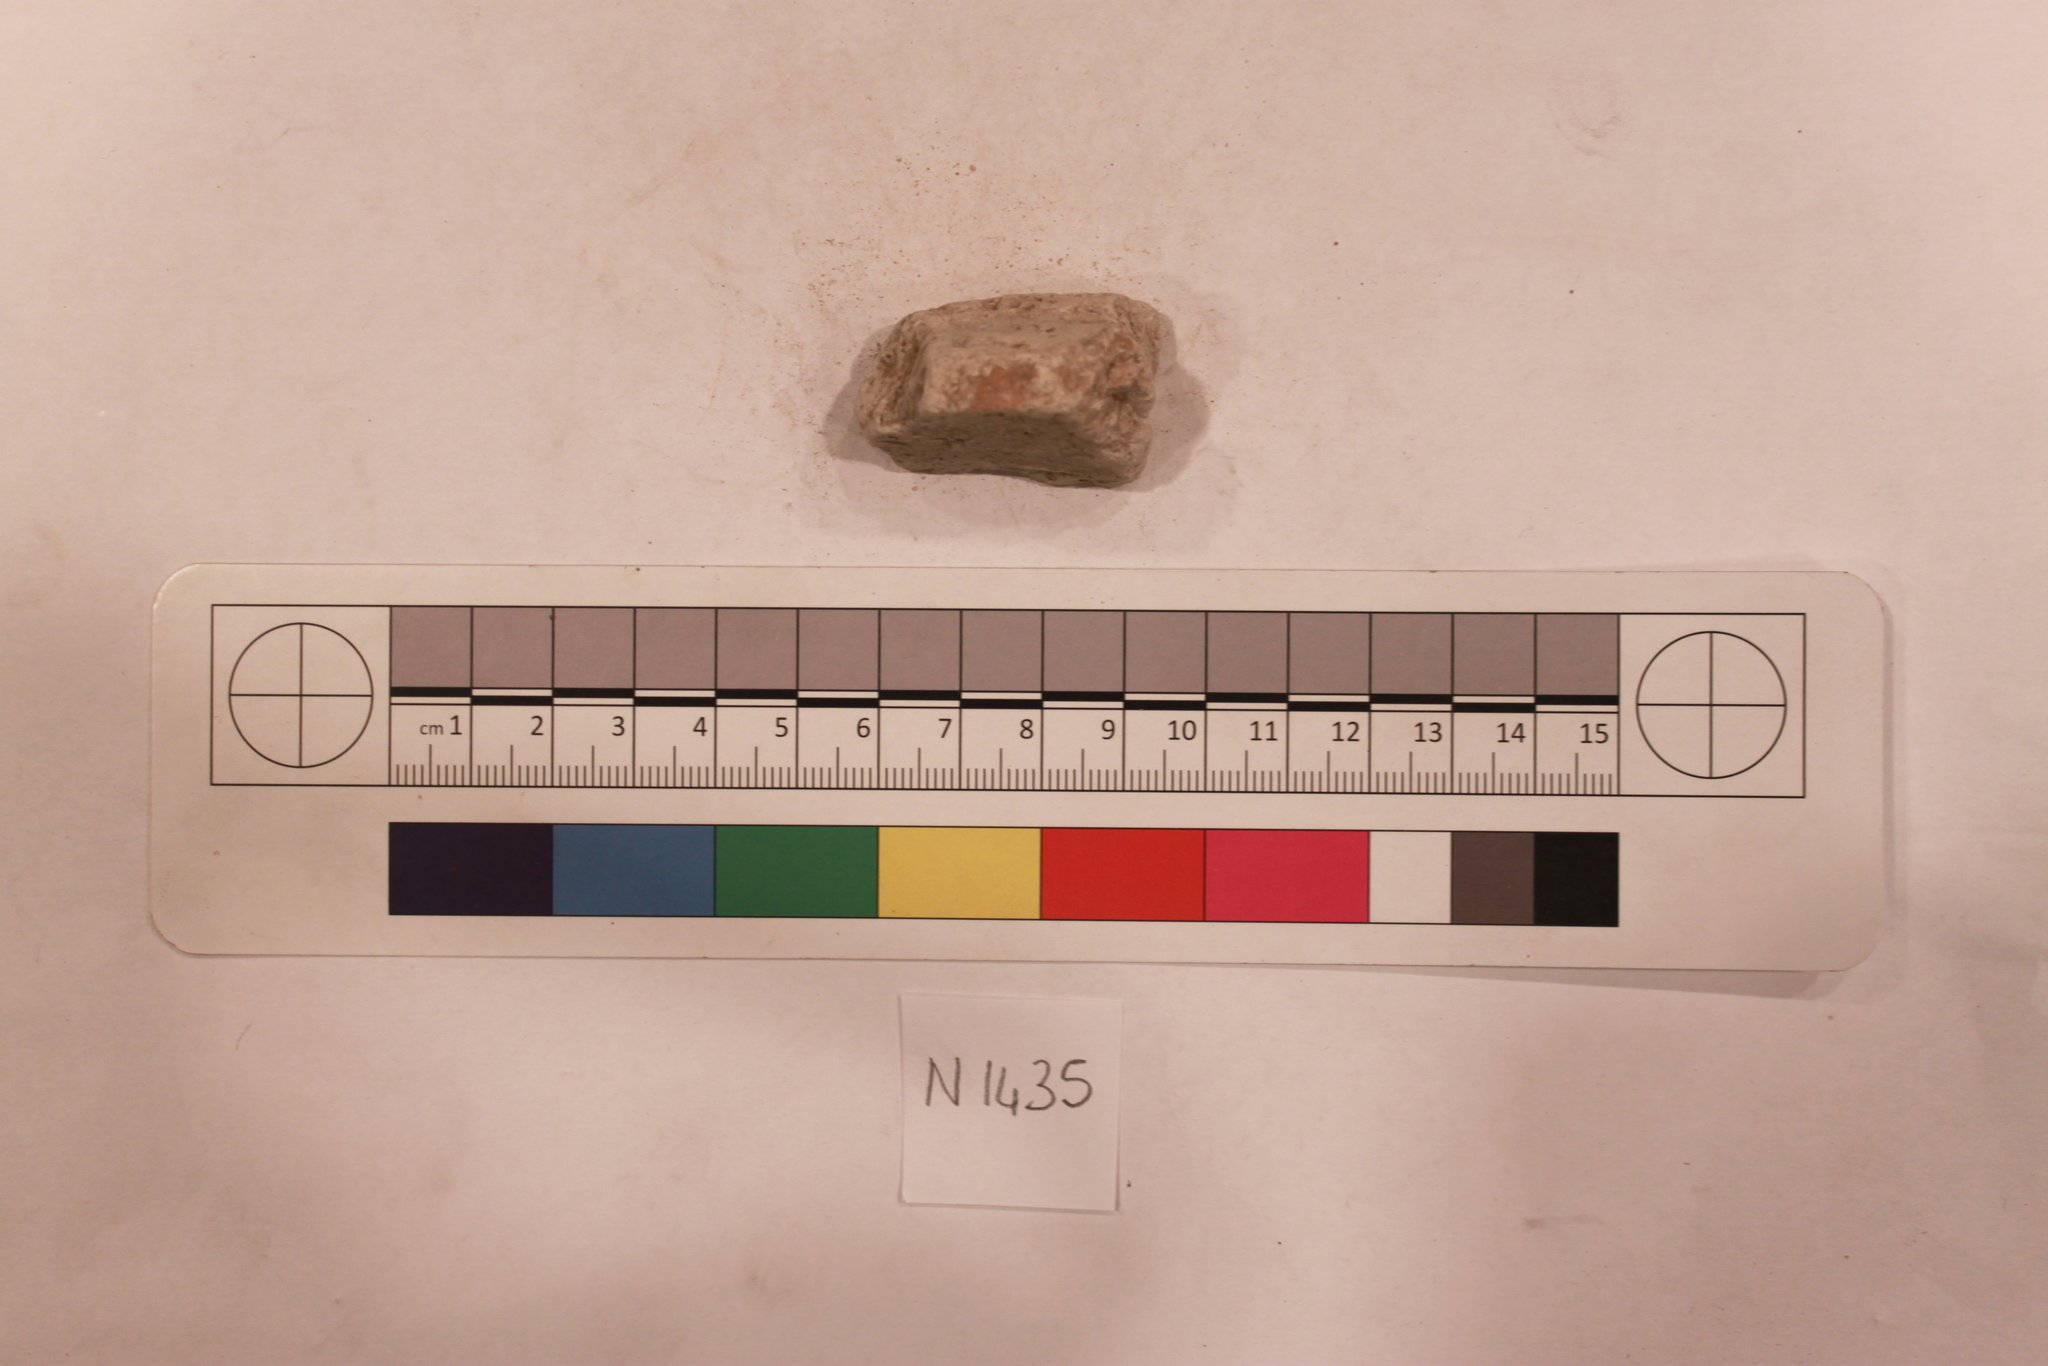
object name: fragment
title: Stucco Fragment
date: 701-1200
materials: plaster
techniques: carving, painting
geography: iran